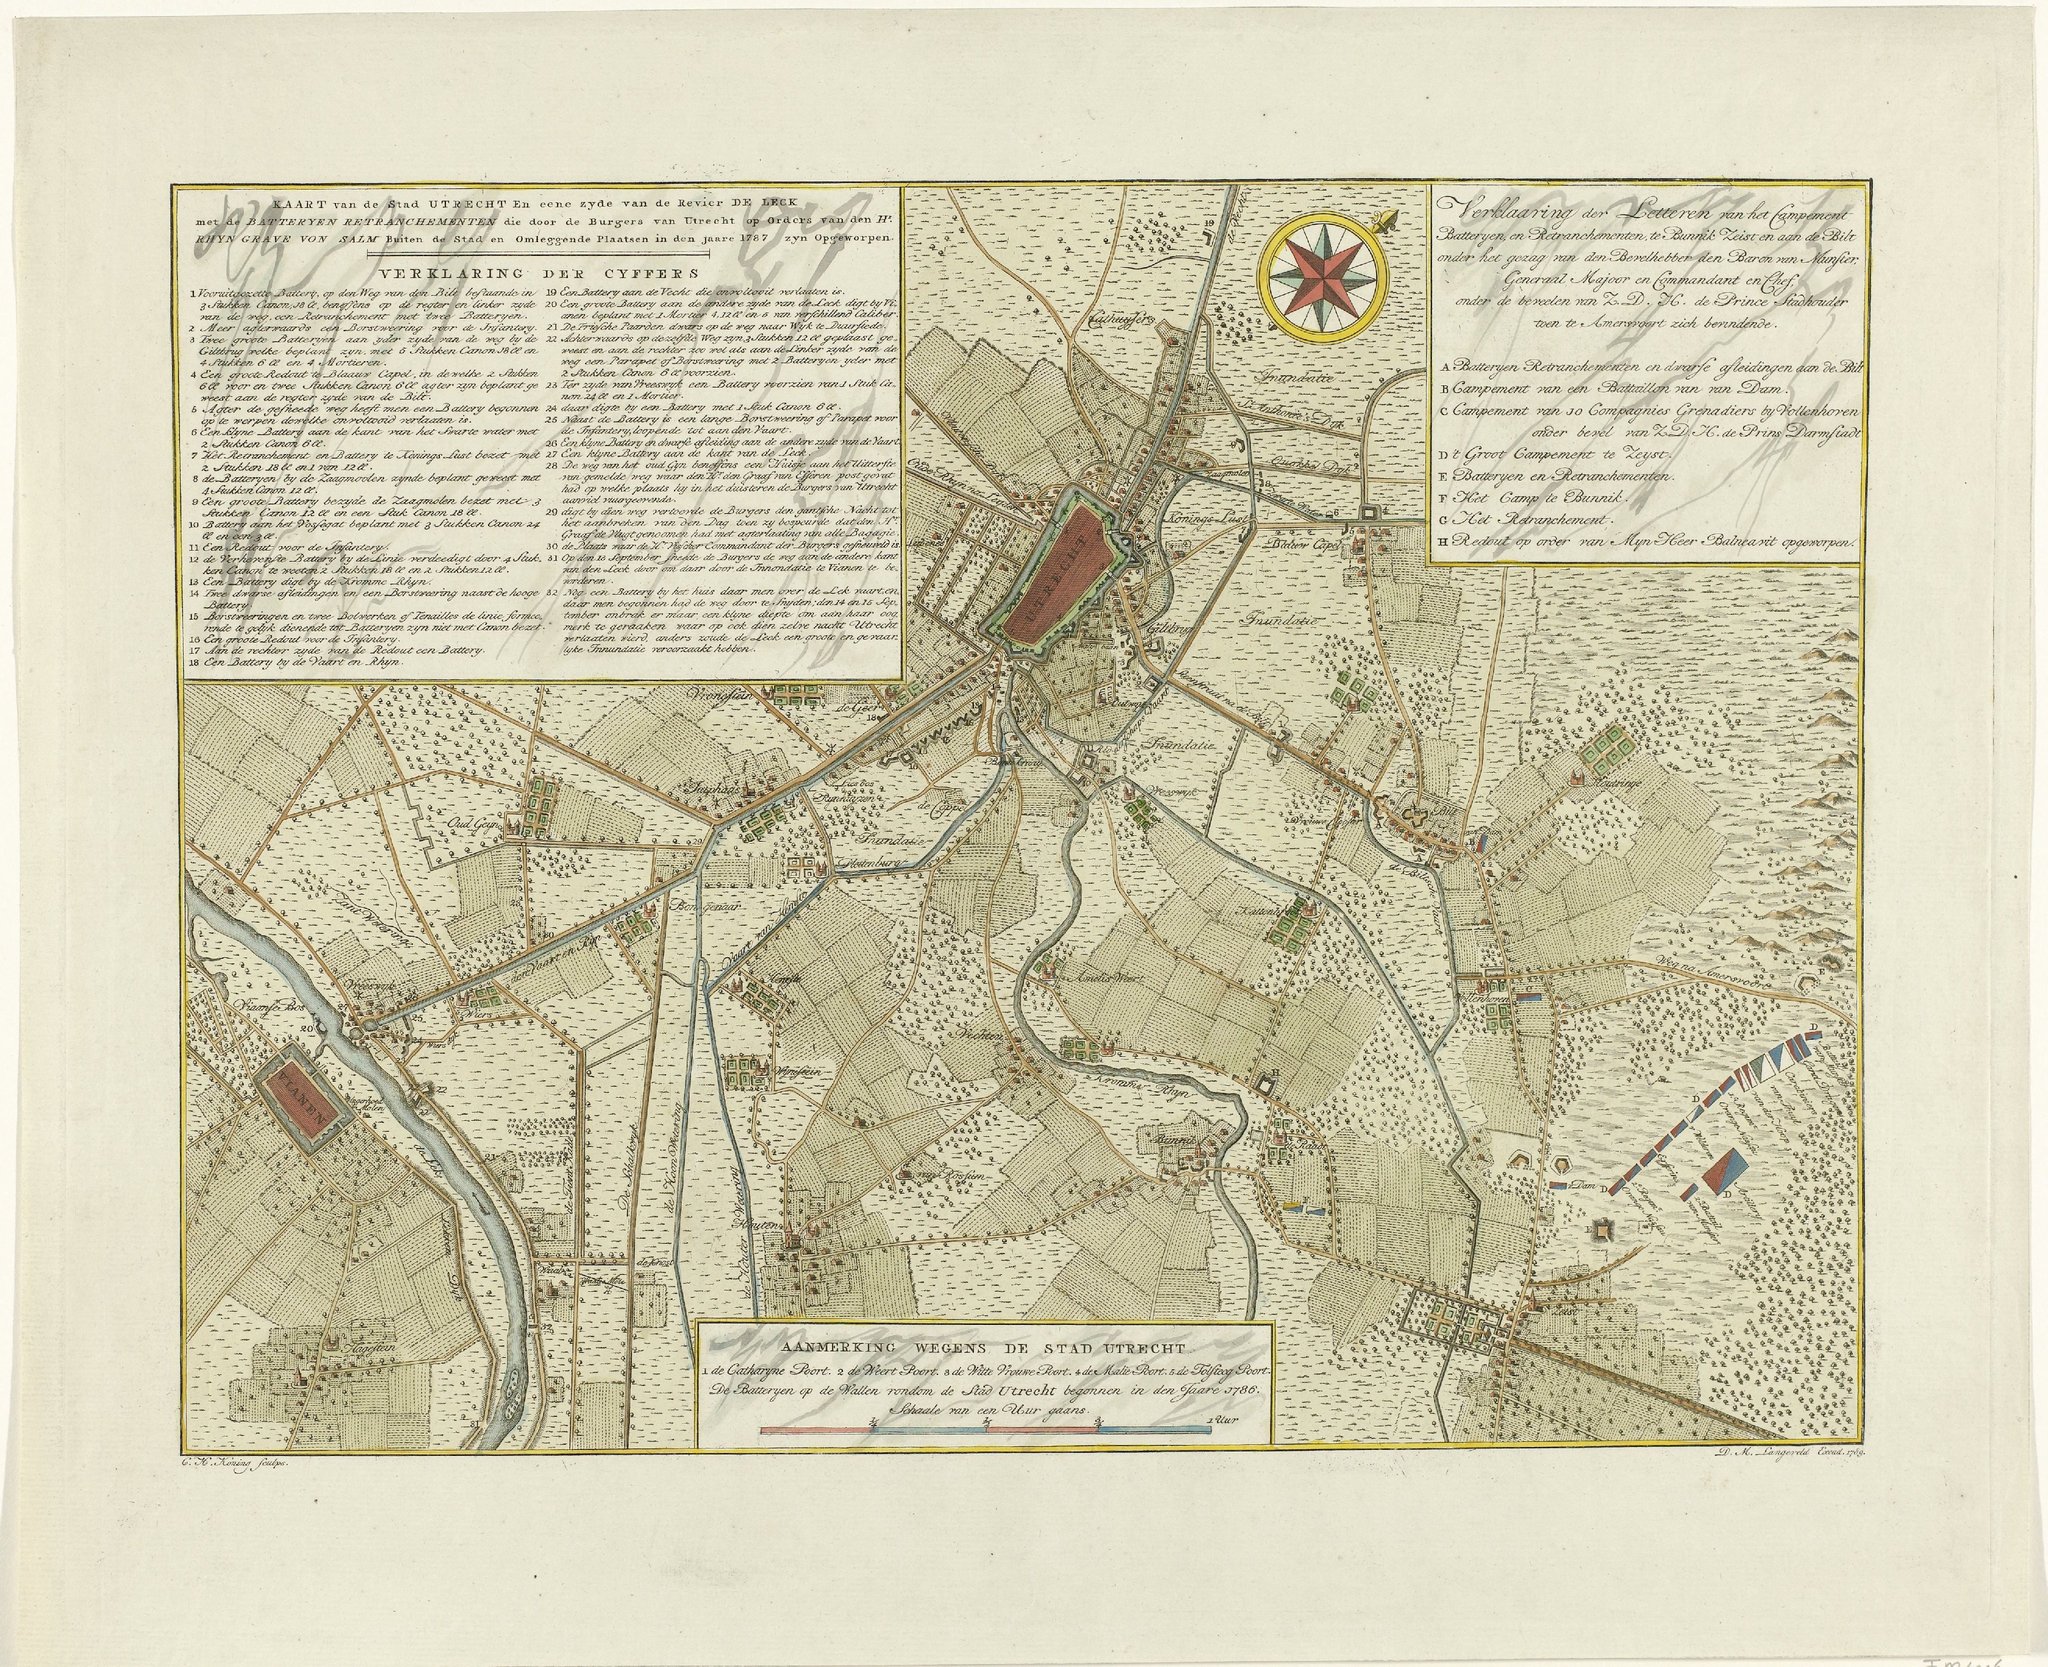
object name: print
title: Kaart van de stad Utrecht en eene zyde van de revier de Leck met de batteryen retranchementen die door de burgers van Utrecht op orders van den Hr. Rhyn Grave von Salm buiten de stad en omleggende plaatsen in den jaare 1787 zyn opgeworpen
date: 1789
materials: paper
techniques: engraving, etching, hand coloring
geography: amsterdam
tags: rijngraaf van salm frederik iii, maps of separate countries or regions, utrecht, patriots (1780-1795)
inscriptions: collector's mark: Lugt 2228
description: Kaart van de stad Utrecht en omgeving, tot aan Vianen, met de batterijen en retranchementen opgericht onder leiding van de Rijngraaf van Salm ter verdediging van de stad tegen het Staatse leger van de stadhouder gelegen bij Amersfoort, september 1787. Met drie cartouches met legenda's. In de onderste cartouche een schaalstok: Schaale van een uur gaans.